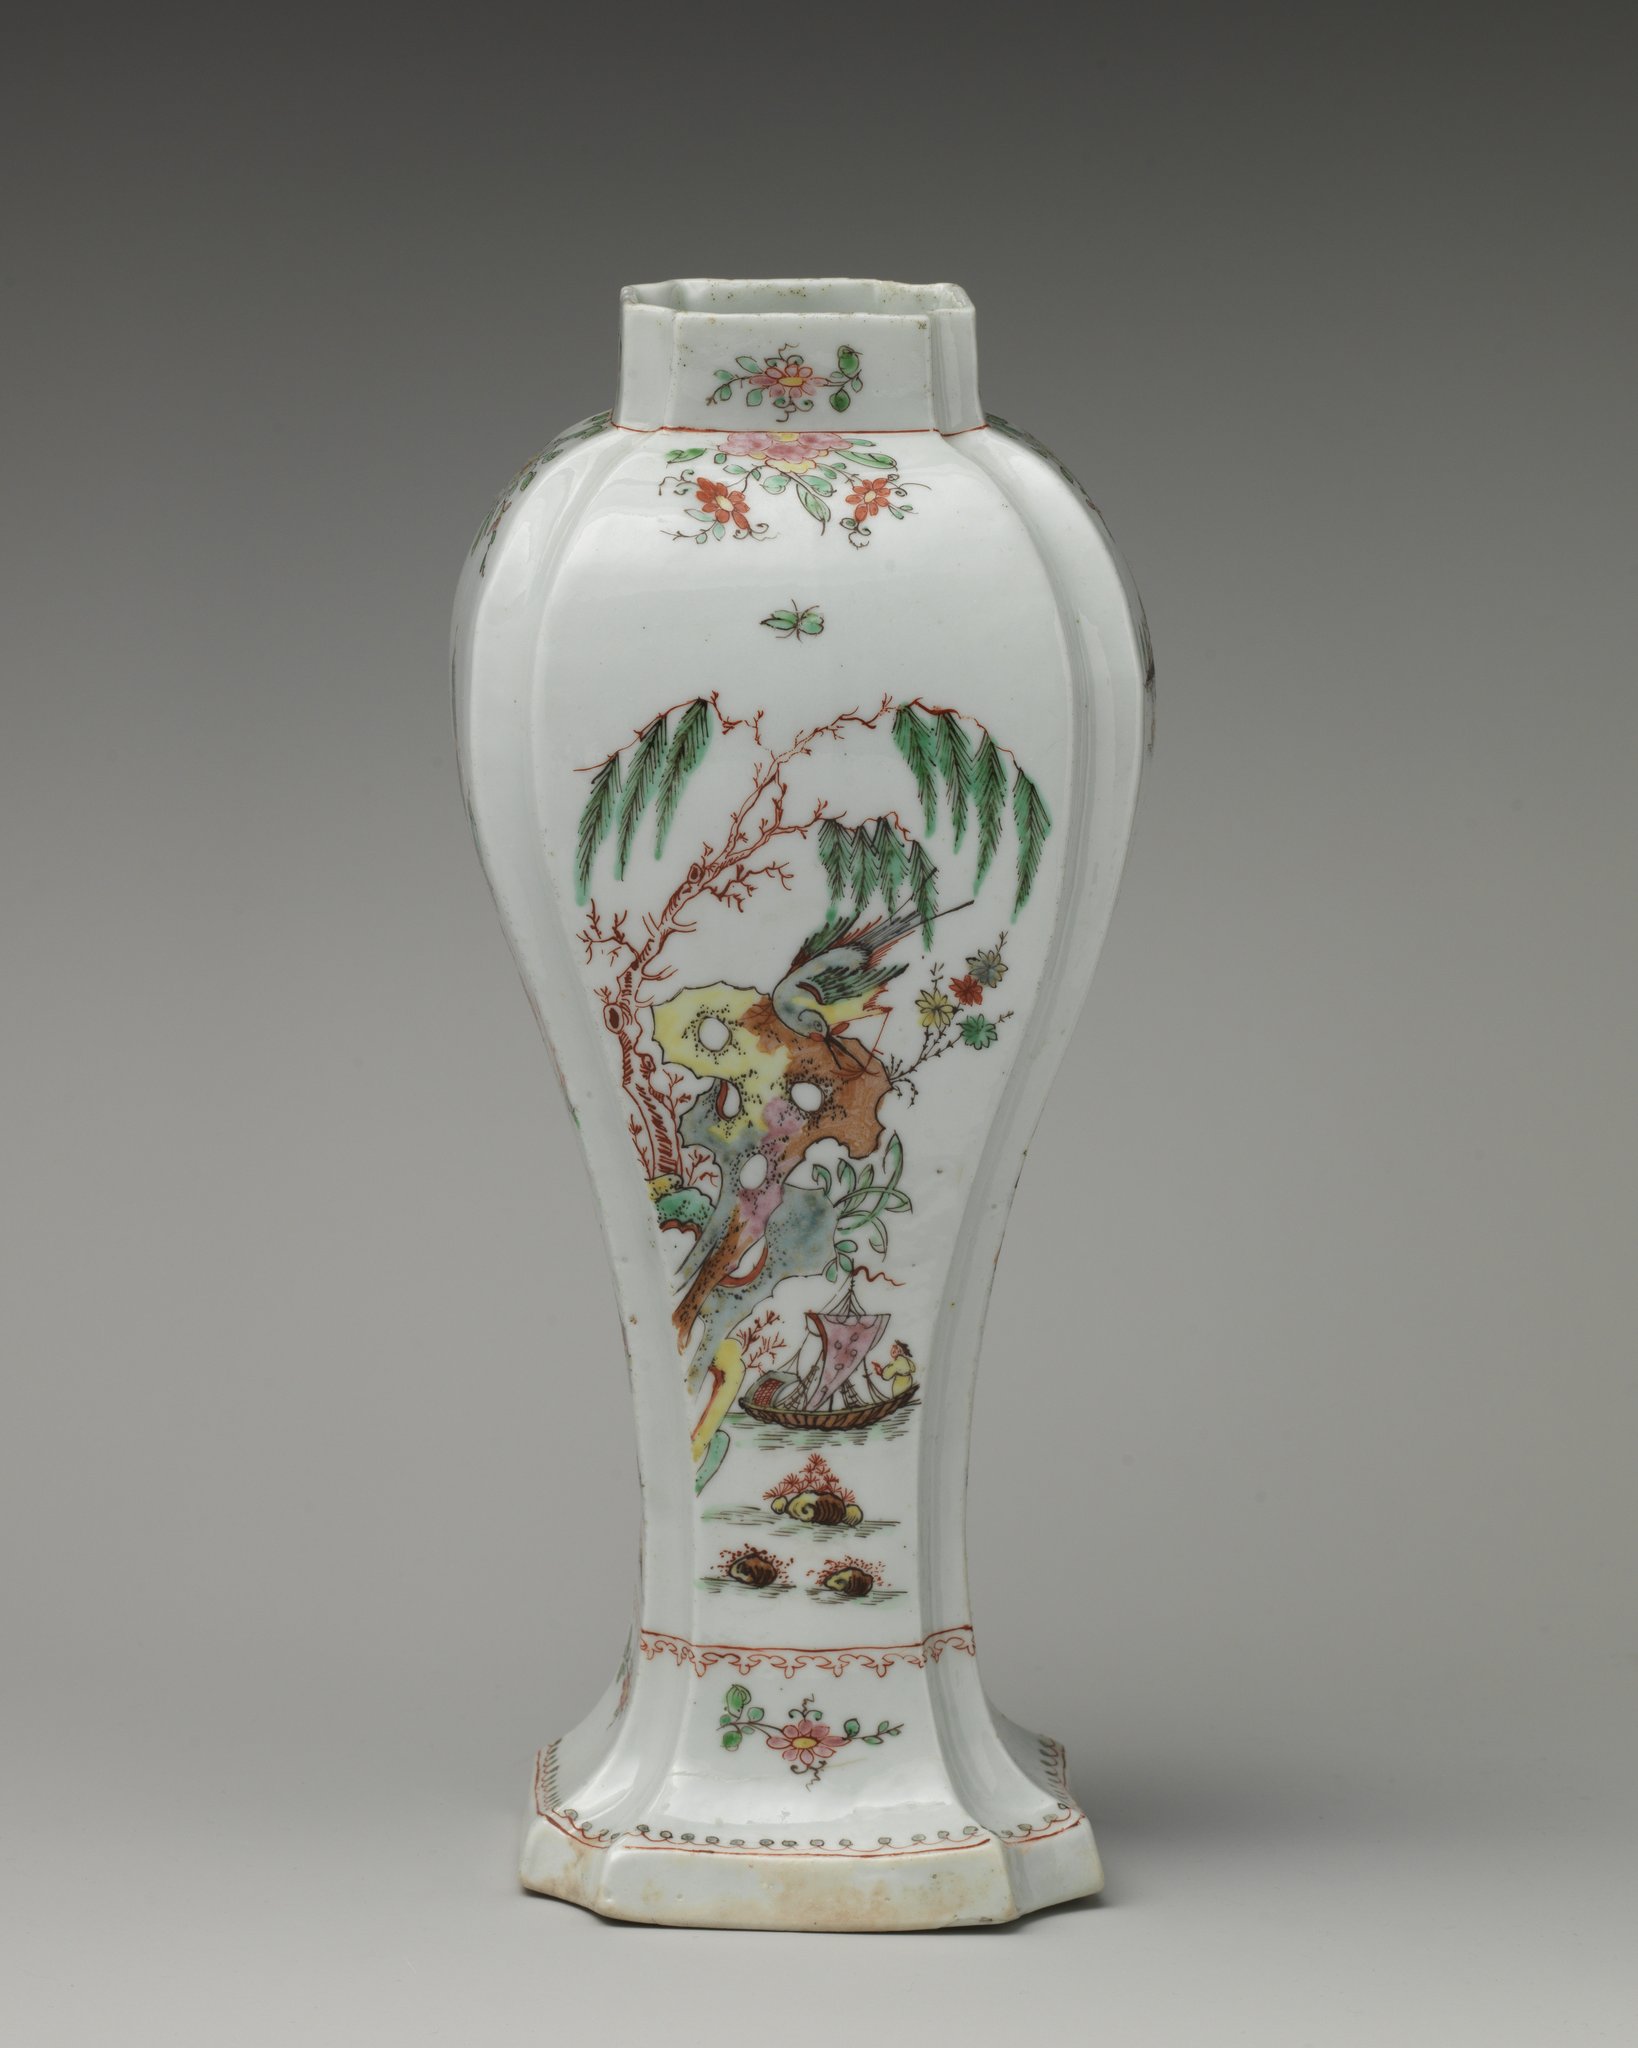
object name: vase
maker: worcester factory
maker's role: factory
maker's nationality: british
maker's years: 1751-2008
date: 1753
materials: enamel, soft paste porcelain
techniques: polychrome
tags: birds,men,trees,boats